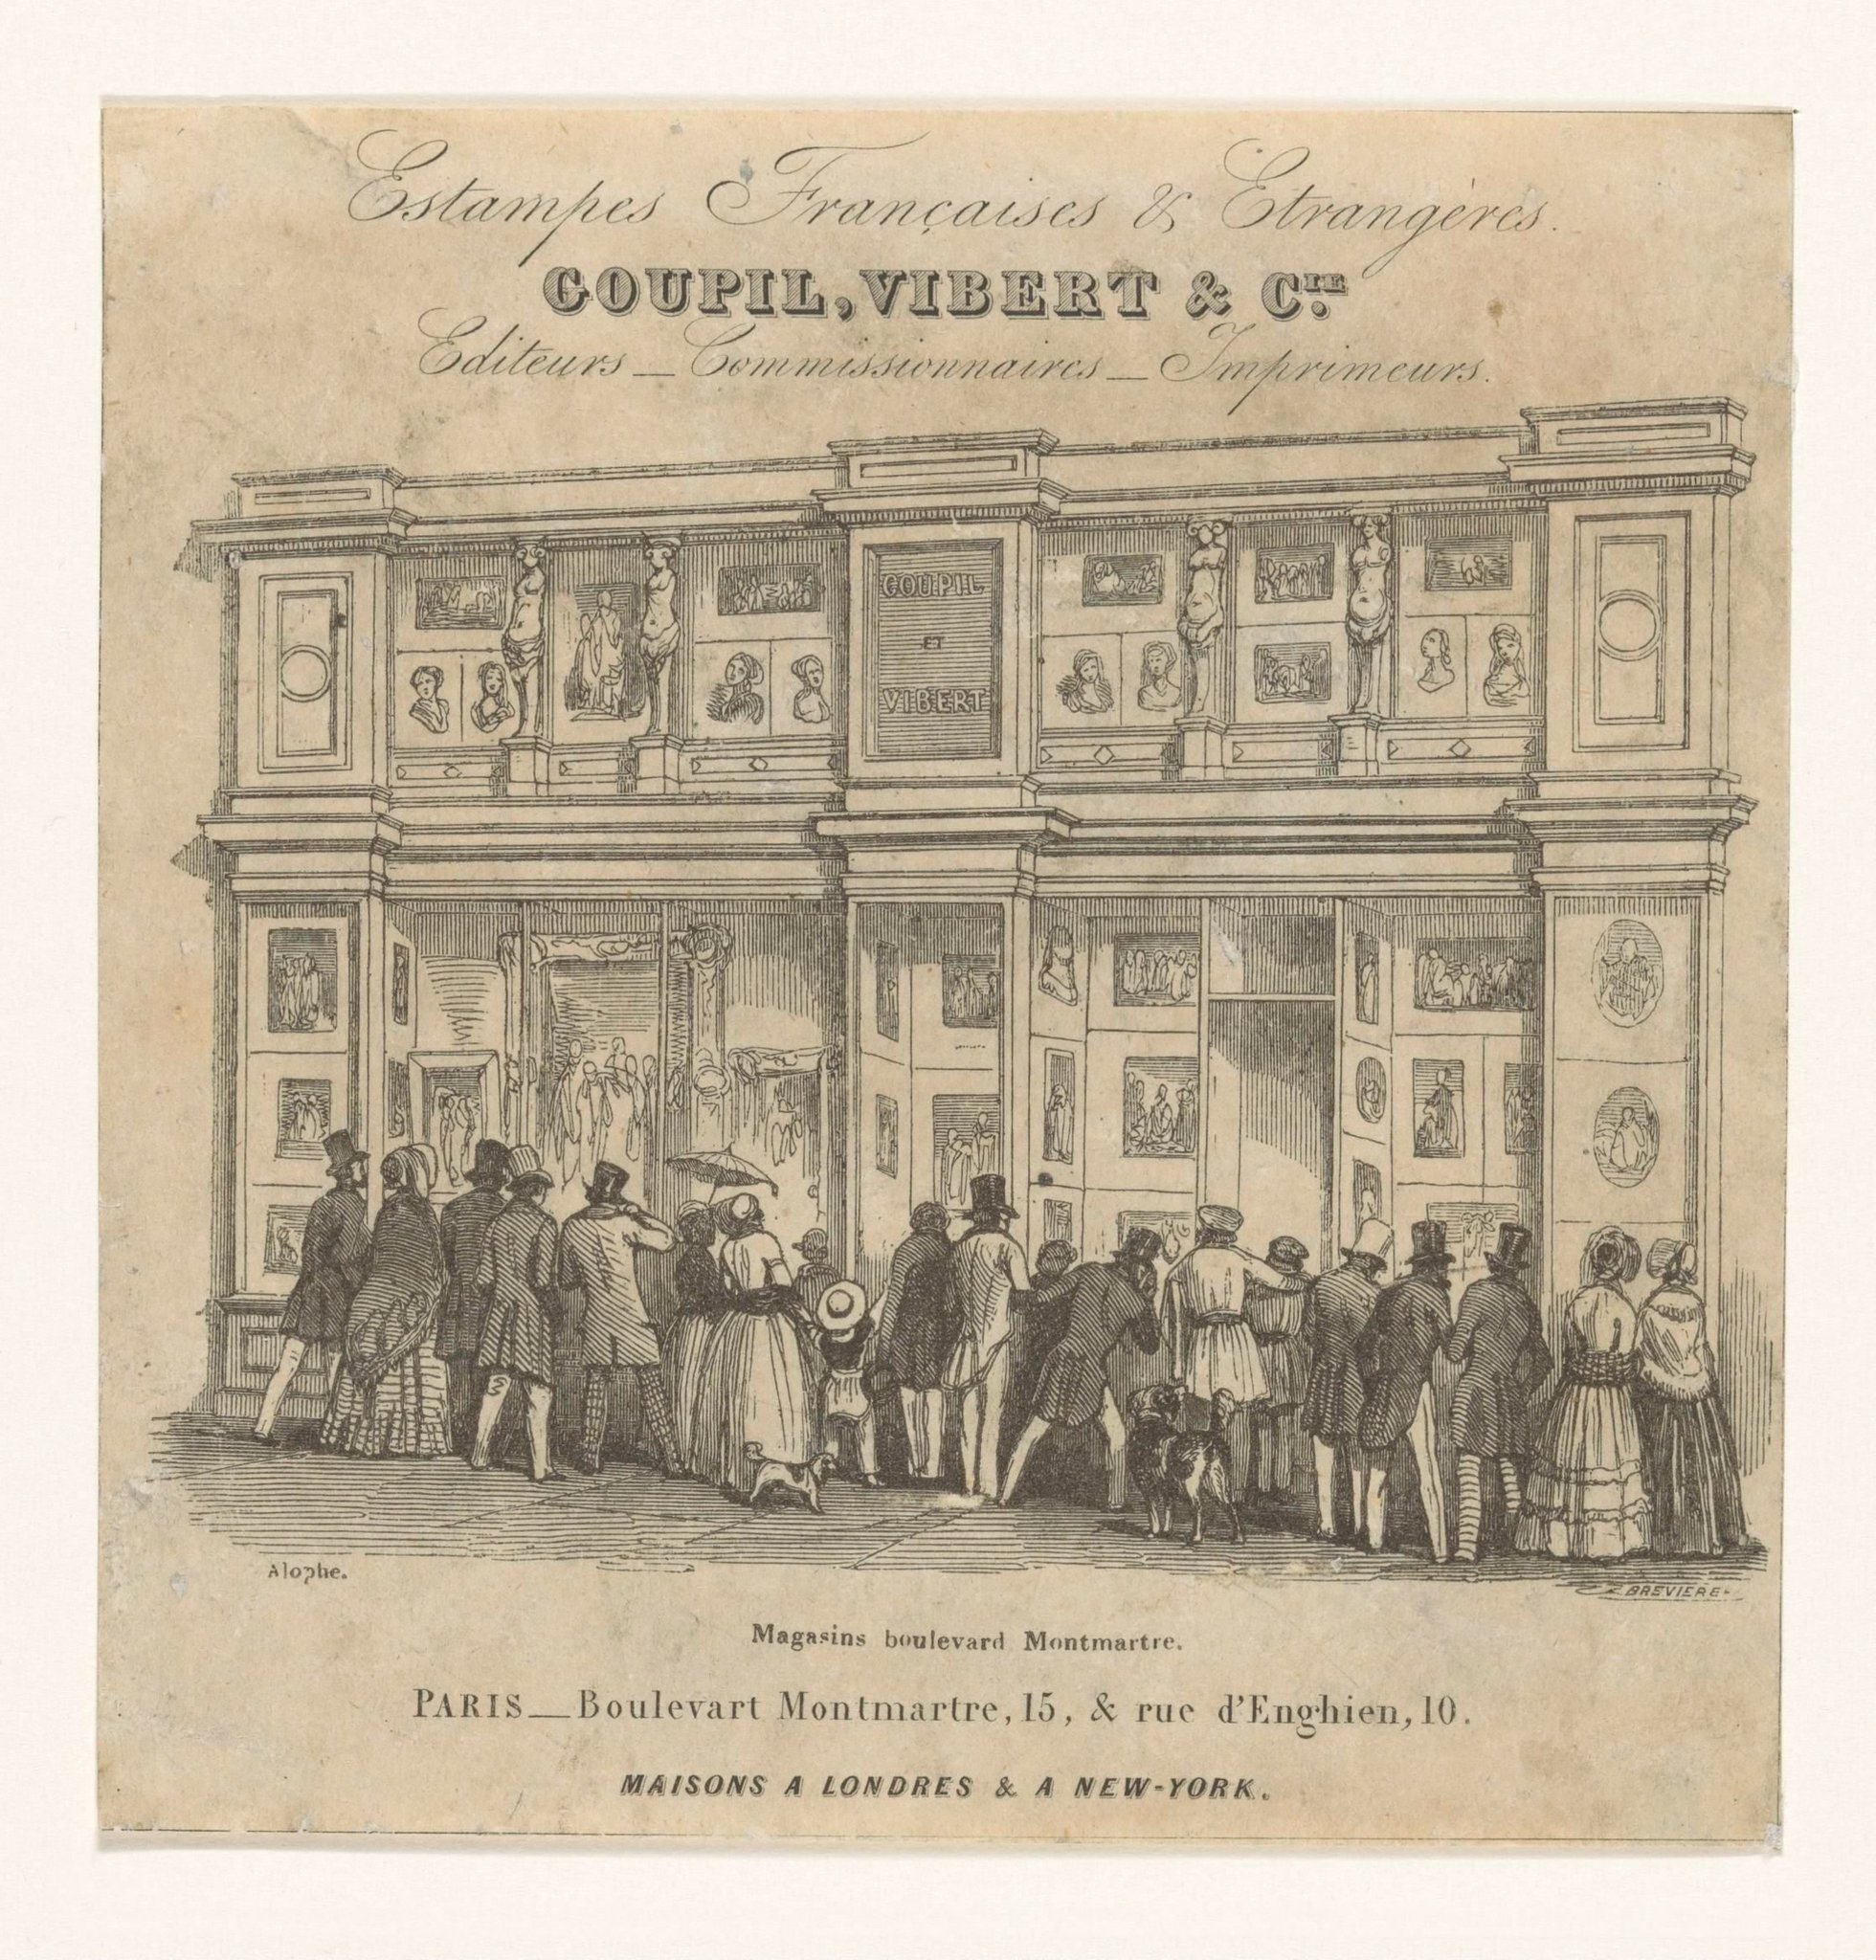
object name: print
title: Estampes Françaises & Etrangères. Goupil, Vibert & Cie. Editeurs - Commissionnaires - Imprimeurs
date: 1845-1850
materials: paper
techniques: letterpress printing, engraving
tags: art dealer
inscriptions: collector's mark: Lugt 4779, collector's mark: Lugt 4780, collector's mark: Lugt 2228